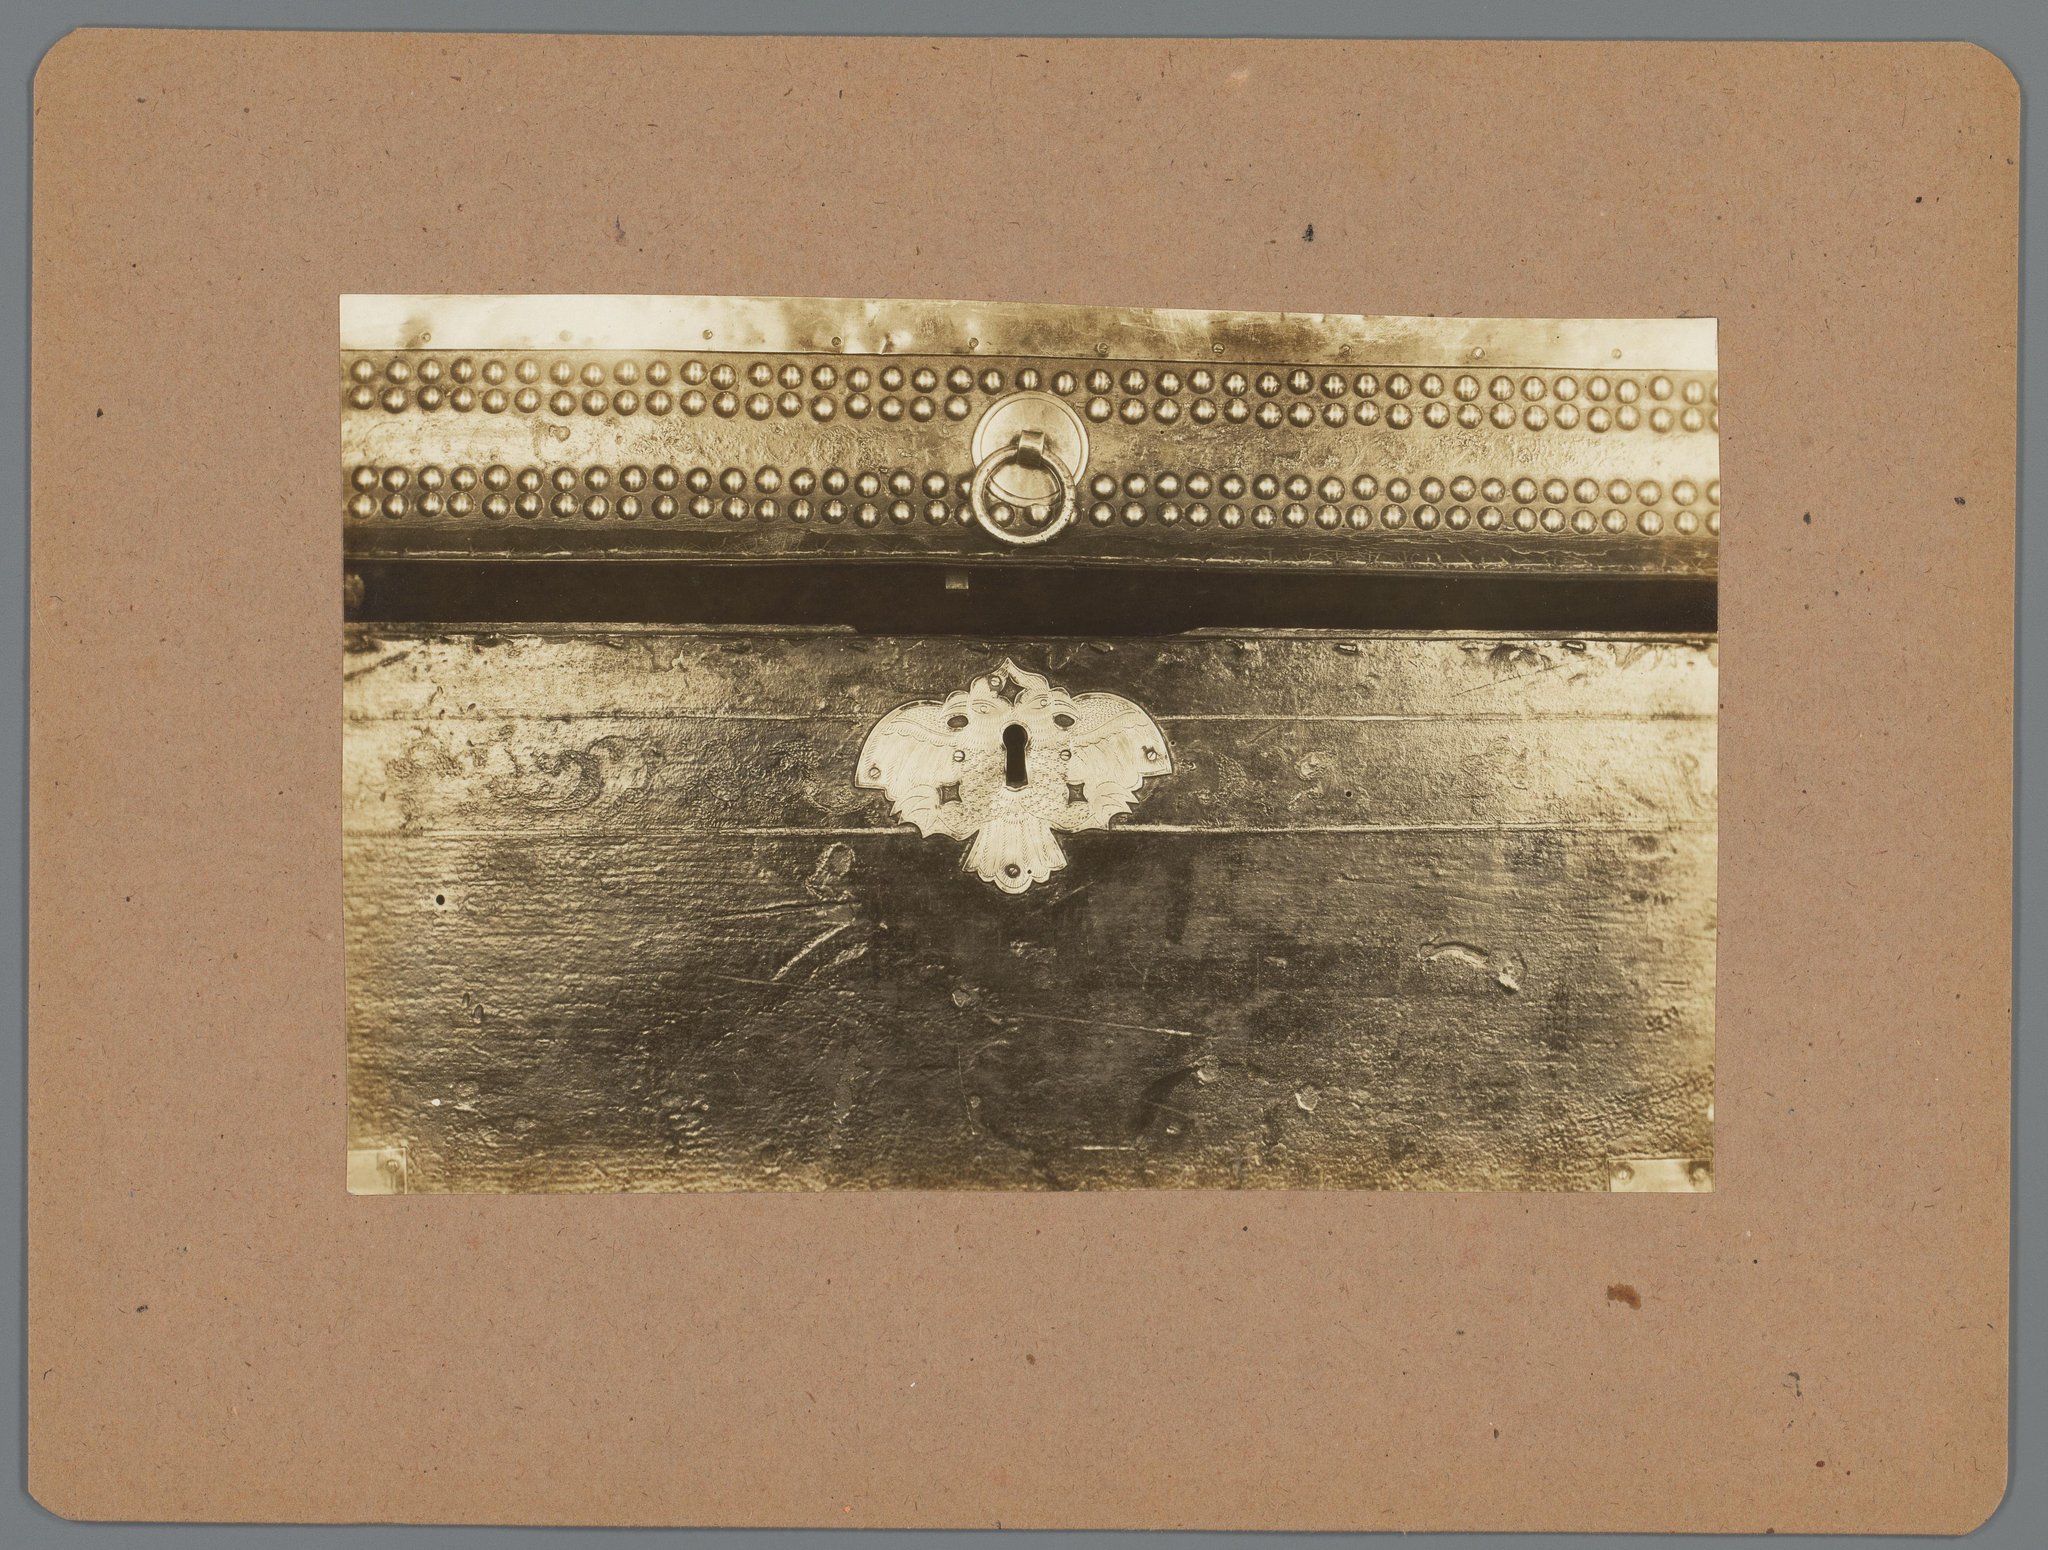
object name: photograph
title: Slot van een koffer van G.H. Howard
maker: Anonymous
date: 1921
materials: paper, cardboard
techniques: gelatin silver print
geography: united states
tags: lock ~ furniture, trunk, suit-case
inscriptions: inscription: ‘Diverse landen’, inscription: ‘Voorzijde v/e koffertje, eigendom van G.H. Howard,/ 32 Westminster Str. Providence R.I./ Zie brief 13 Jan. 1921./ 32 inches long, 17 inches wide, 14 inches high./ Made of camphor wood, covered with dark green leather with floral/ decorations, brass bound & studded with brass nails./ 18de eeuw.’